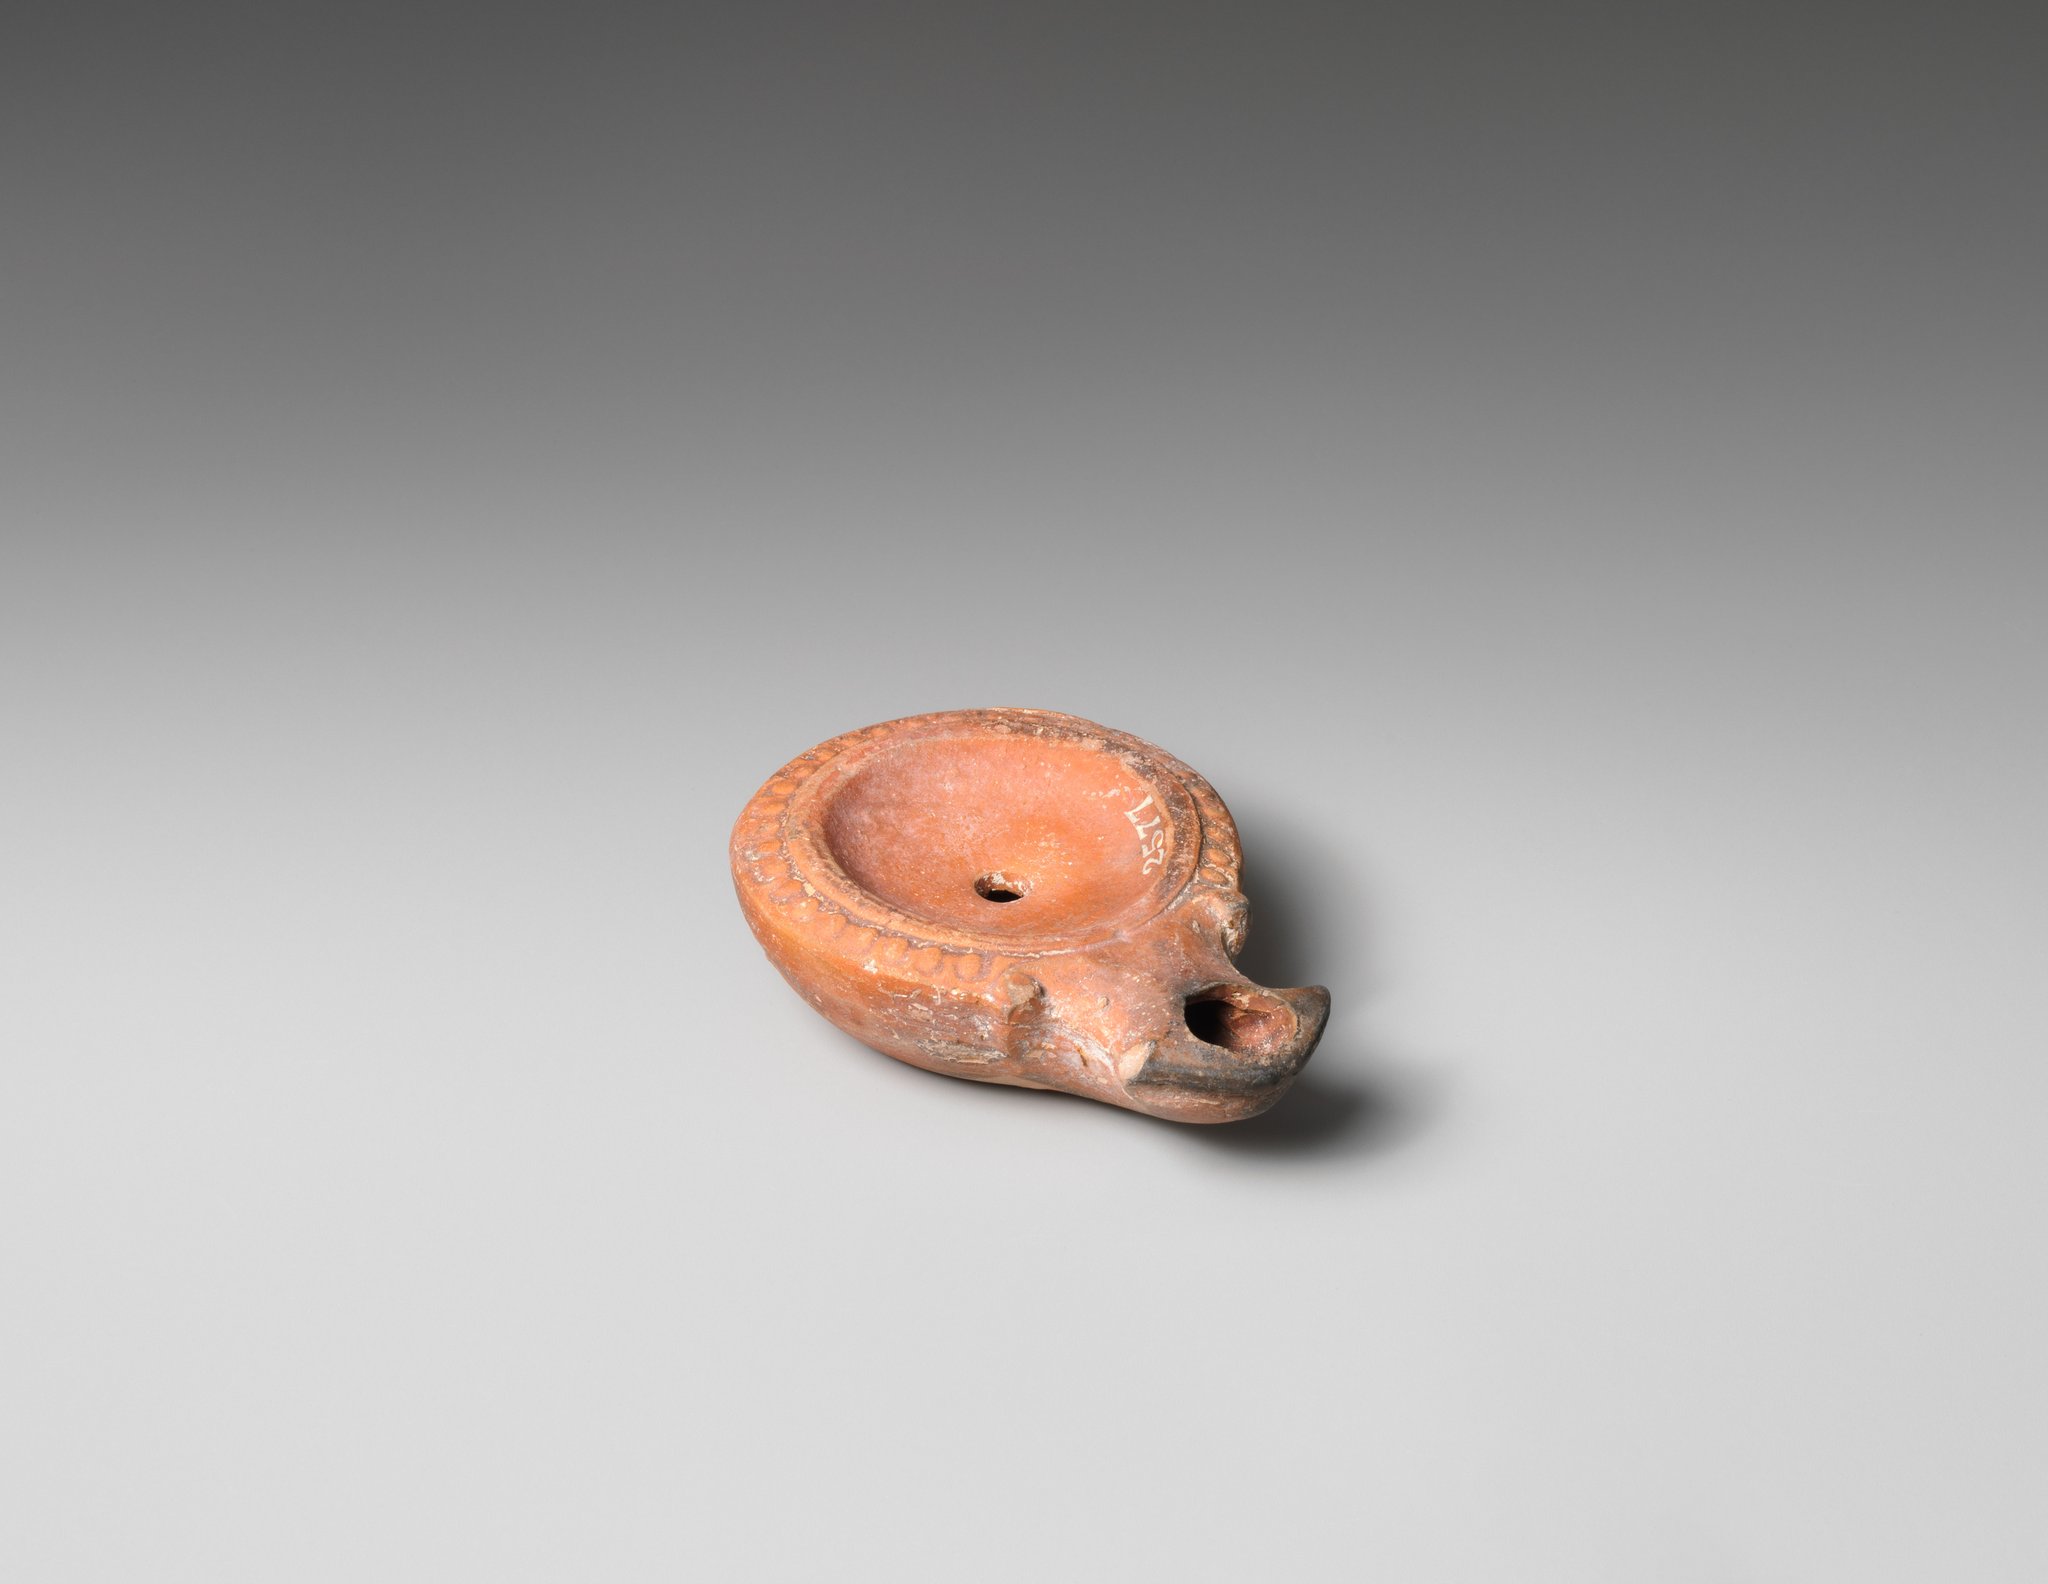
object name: lamp, concave top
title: Terracotta oil lamp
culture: roman, cypriot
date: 100 BCE-100 CE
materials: terracotta